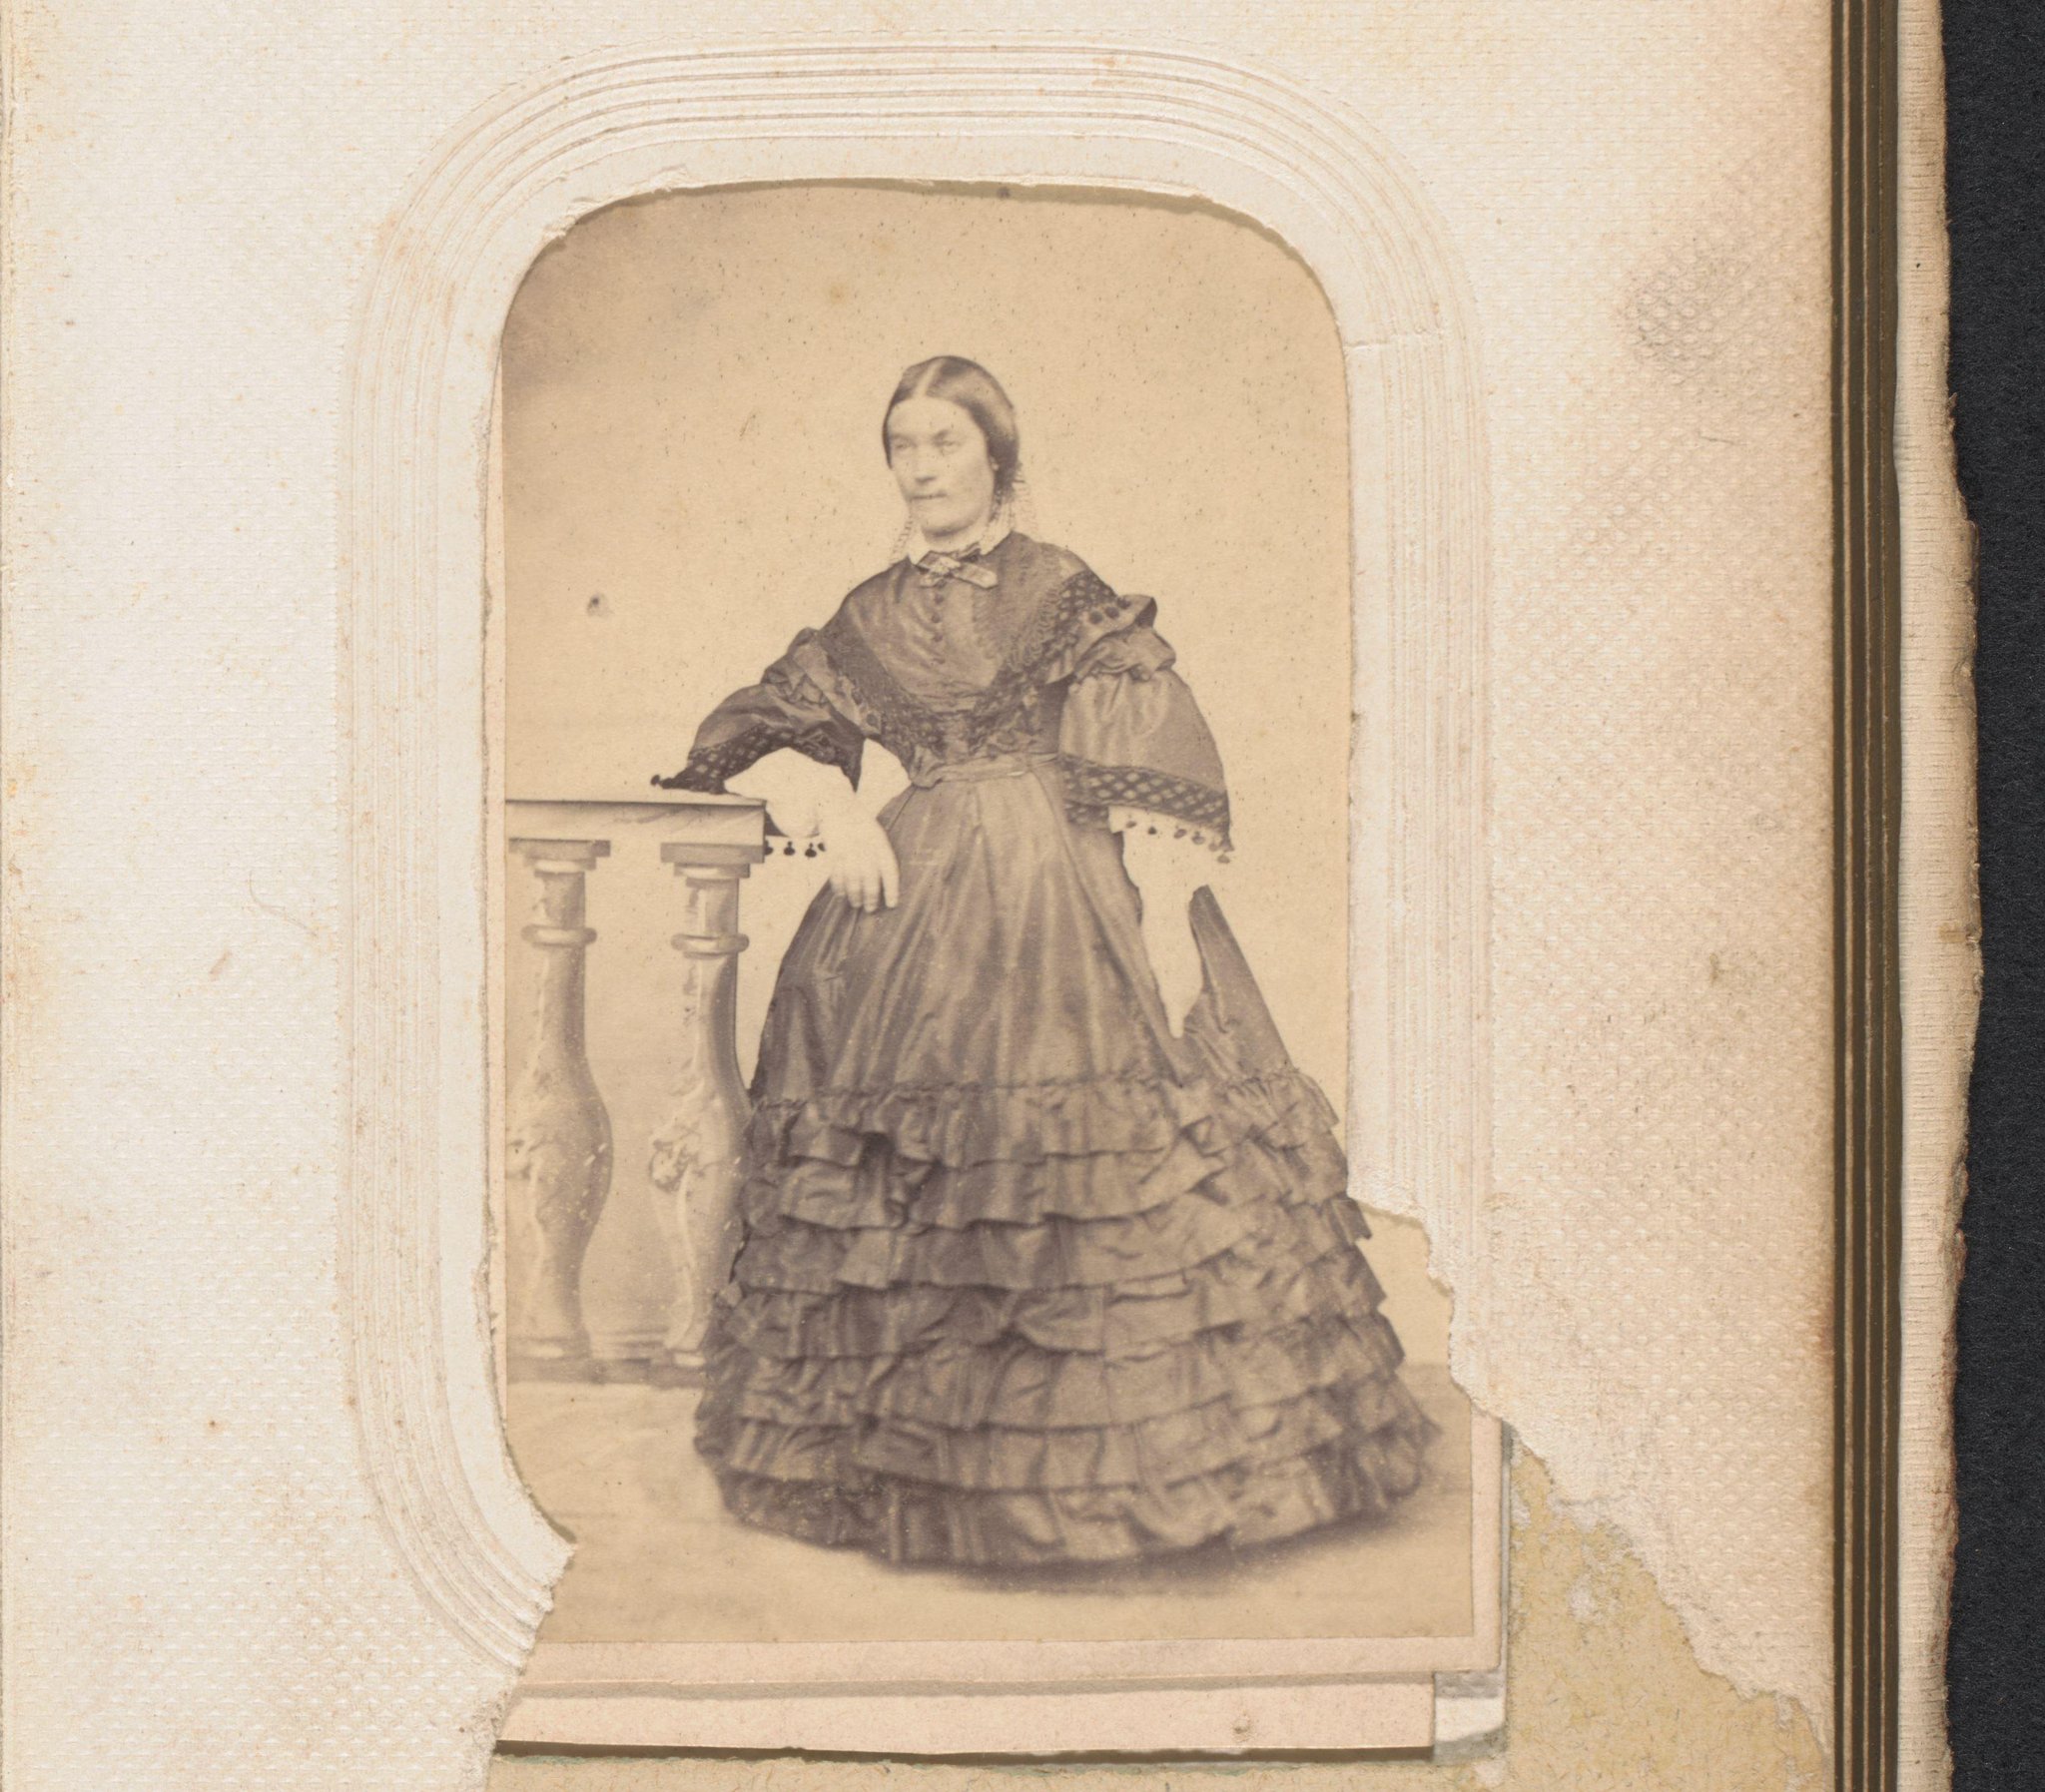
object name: photograph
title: Portret van een staande vrouw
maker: Anonymous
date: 1860-1870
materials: cardboard, photographic support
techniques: albumen print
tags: adult woman, historical persons